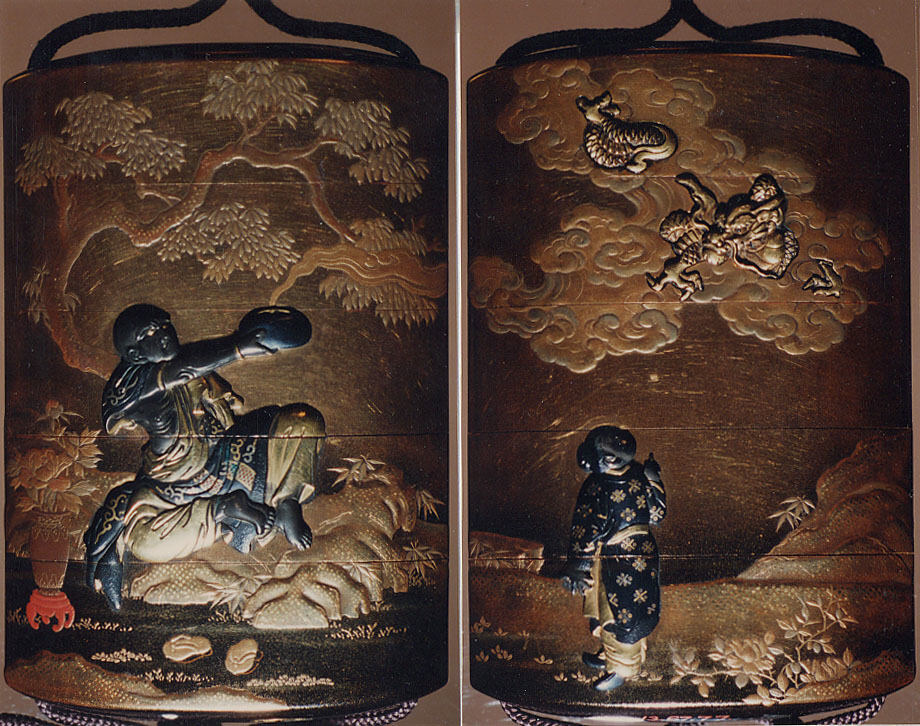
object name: inrō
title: Case (Inrō) with Design of Magician Handaka Sonja Seated beneath Tree (obverse); Karako Pointing at Dragon in Sky (reverse)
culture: japanese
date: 1801-1900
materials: gold, lacquer, metal, silver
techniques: fundame, hiramakie, inlay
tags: men,dragons,trees